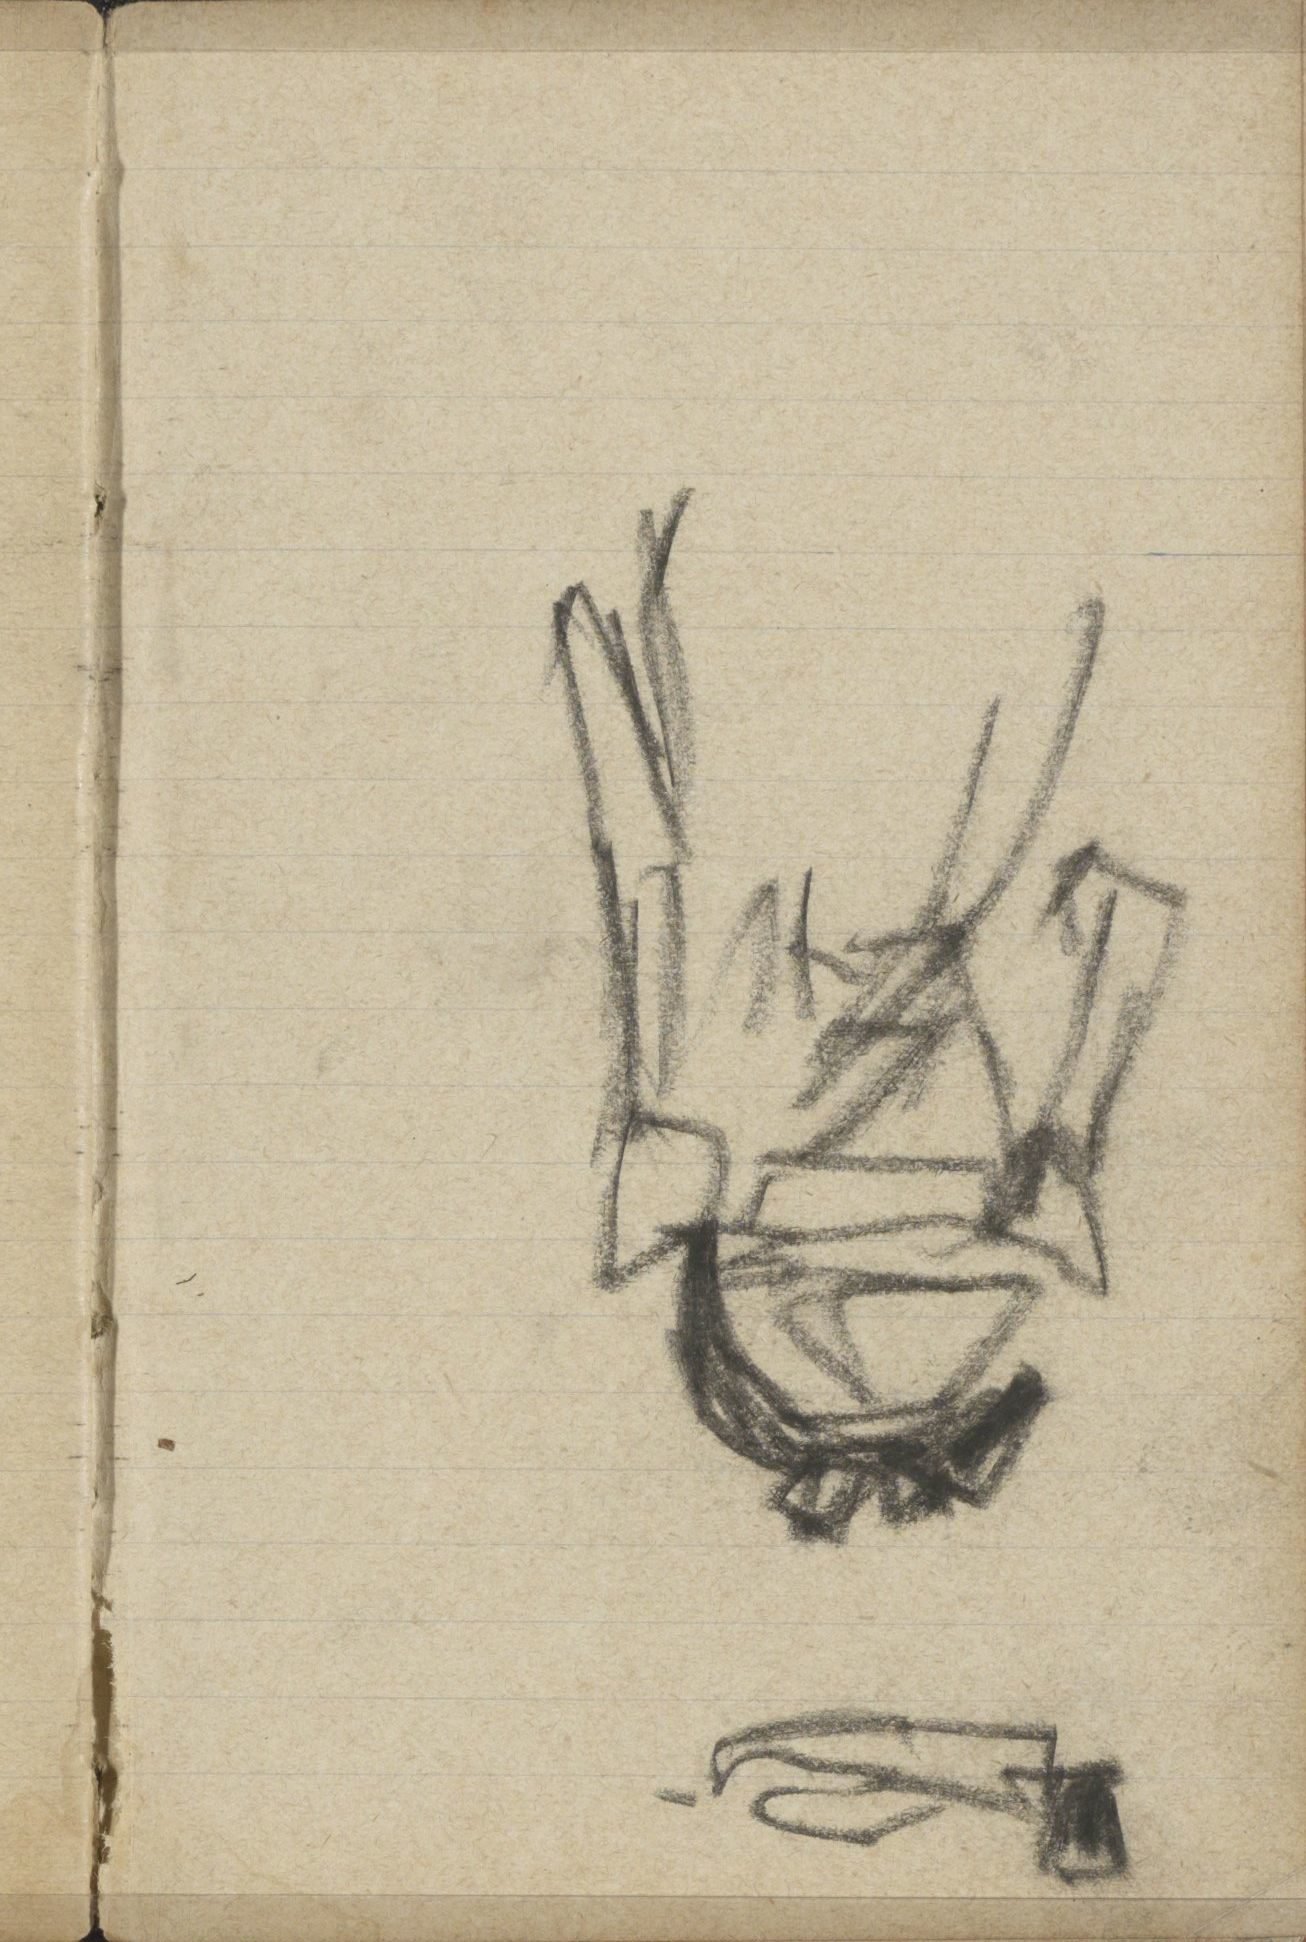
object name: sketchbook leaf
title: Vrouw, op de rug gezien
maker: george hendrik breitner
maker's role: draughtsman, painter, print maker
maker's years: 1857-1923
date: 1886-1903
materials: chalk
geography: amsterdam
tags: adult woman (+ back view), head-gear: hat (+ women's clothes)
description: Verder mogelijk een hoed. Pagina 56 uit een schetsboek met 41 bladen.